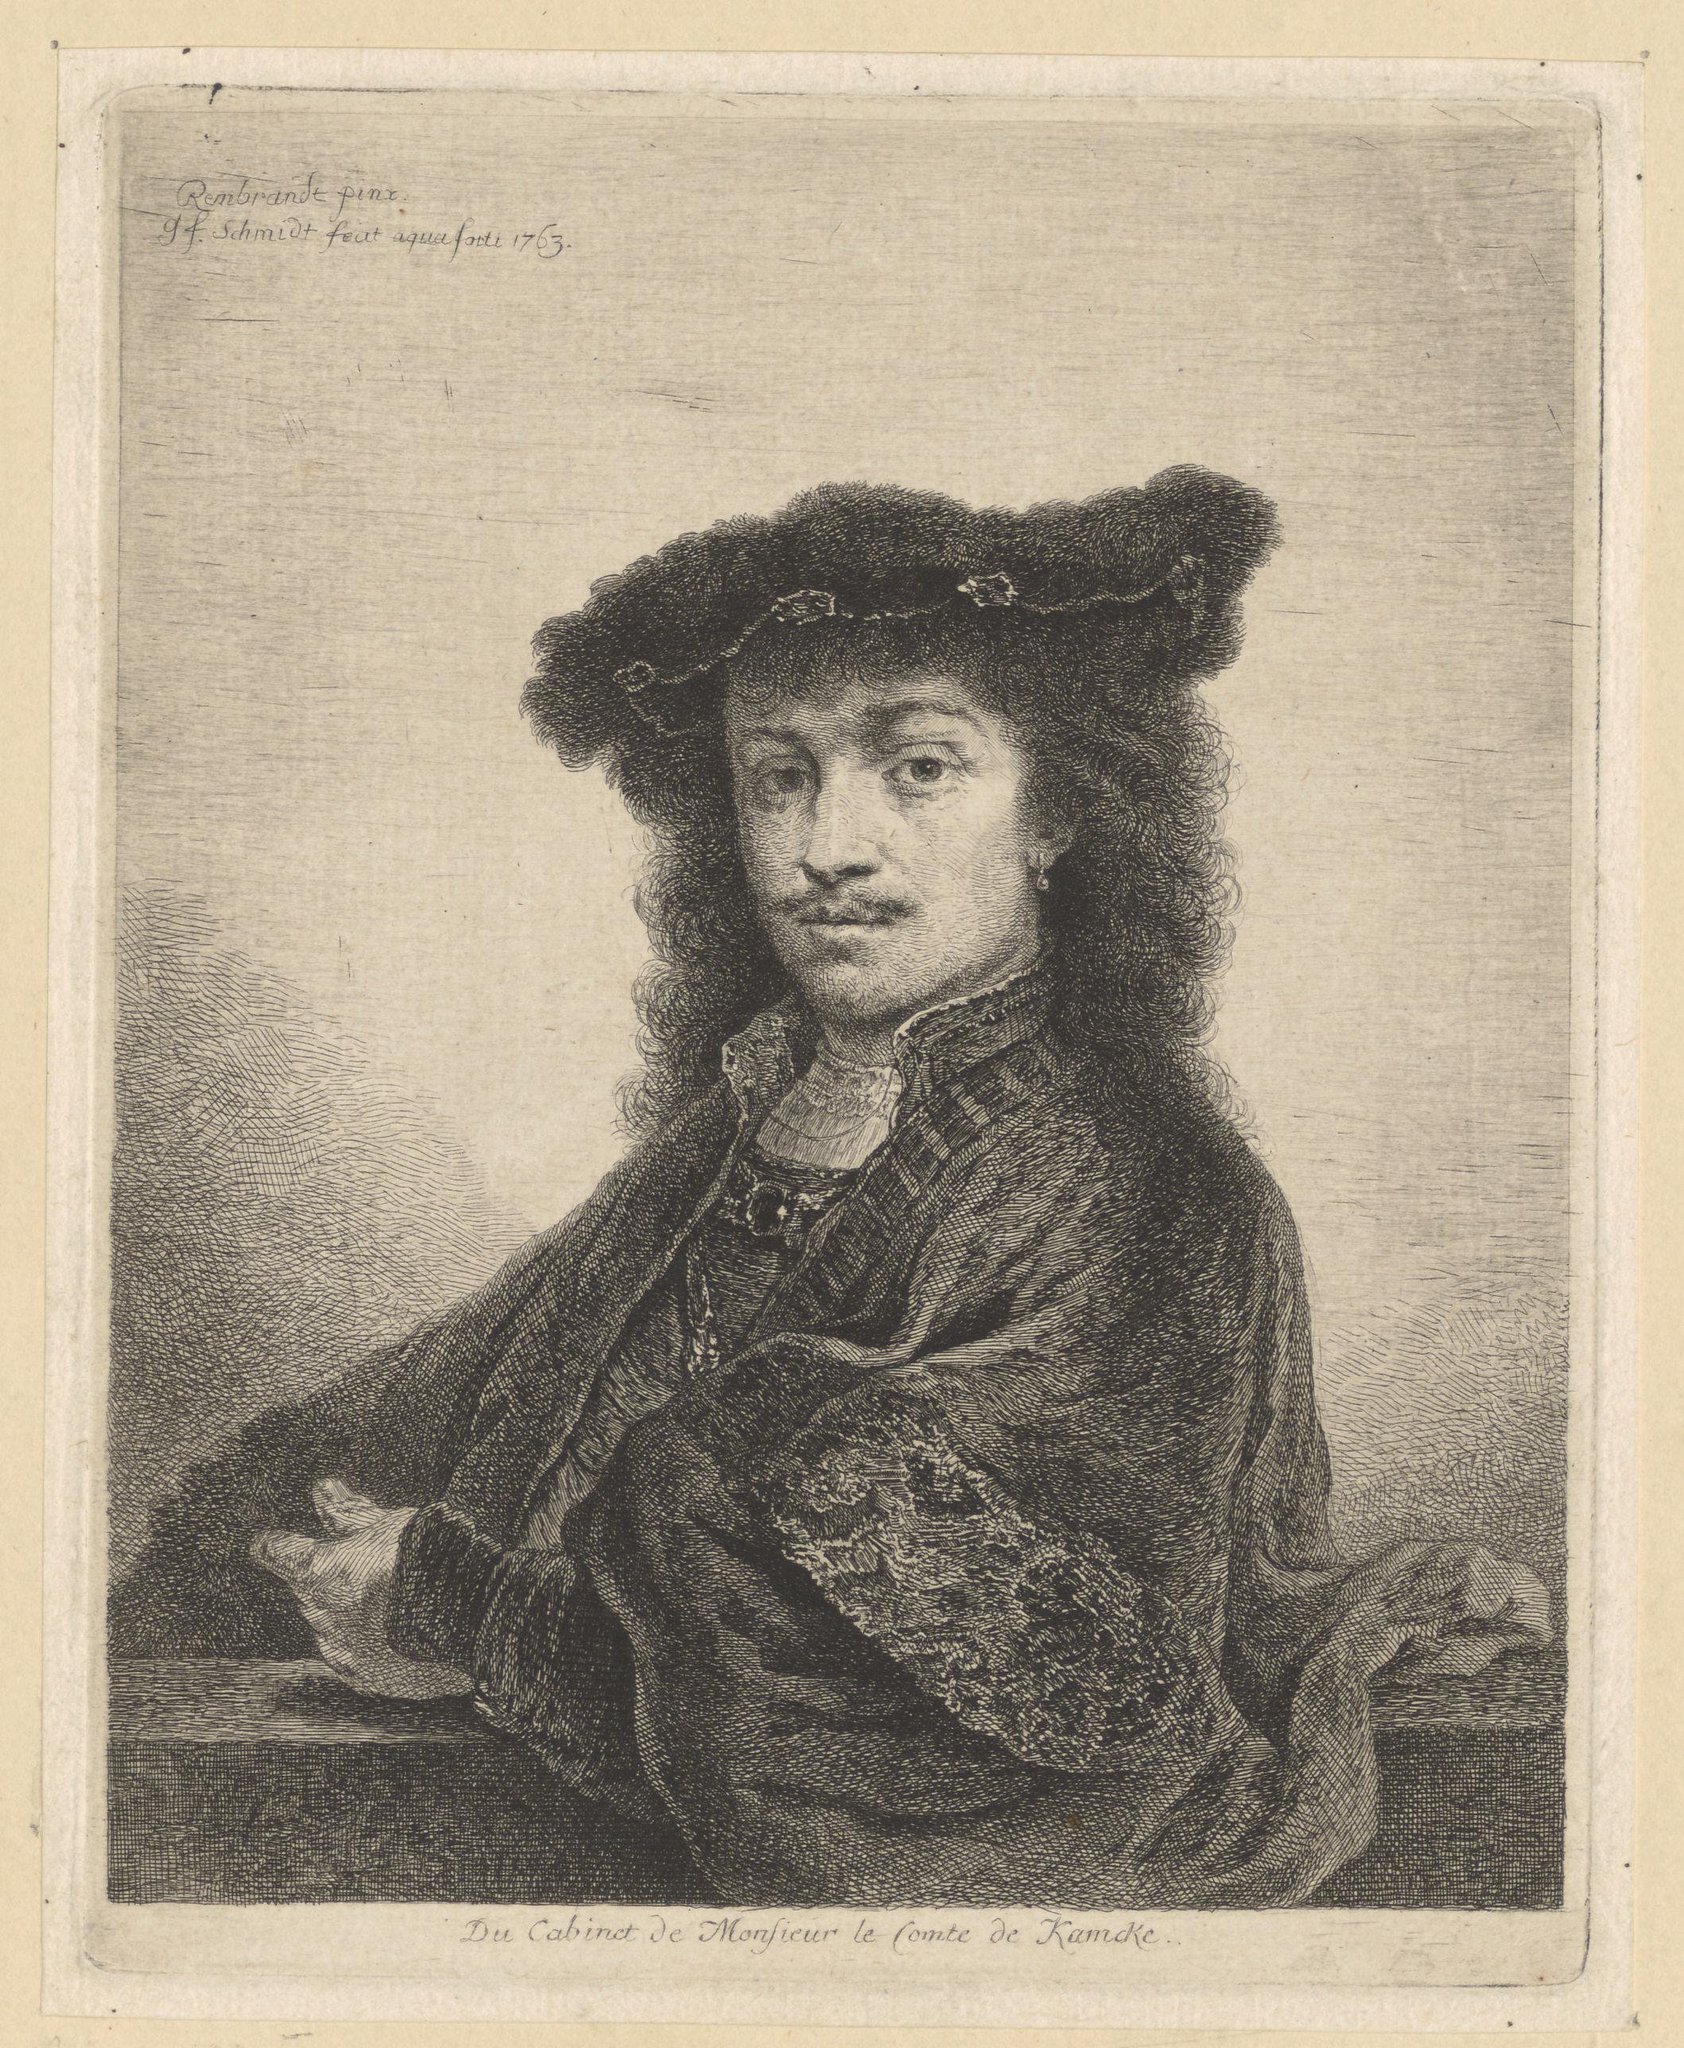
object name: print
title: Portret van een onbekende man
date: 1763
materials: paper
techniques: etching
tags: historical persons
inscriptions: collector's mark: Lugt 240